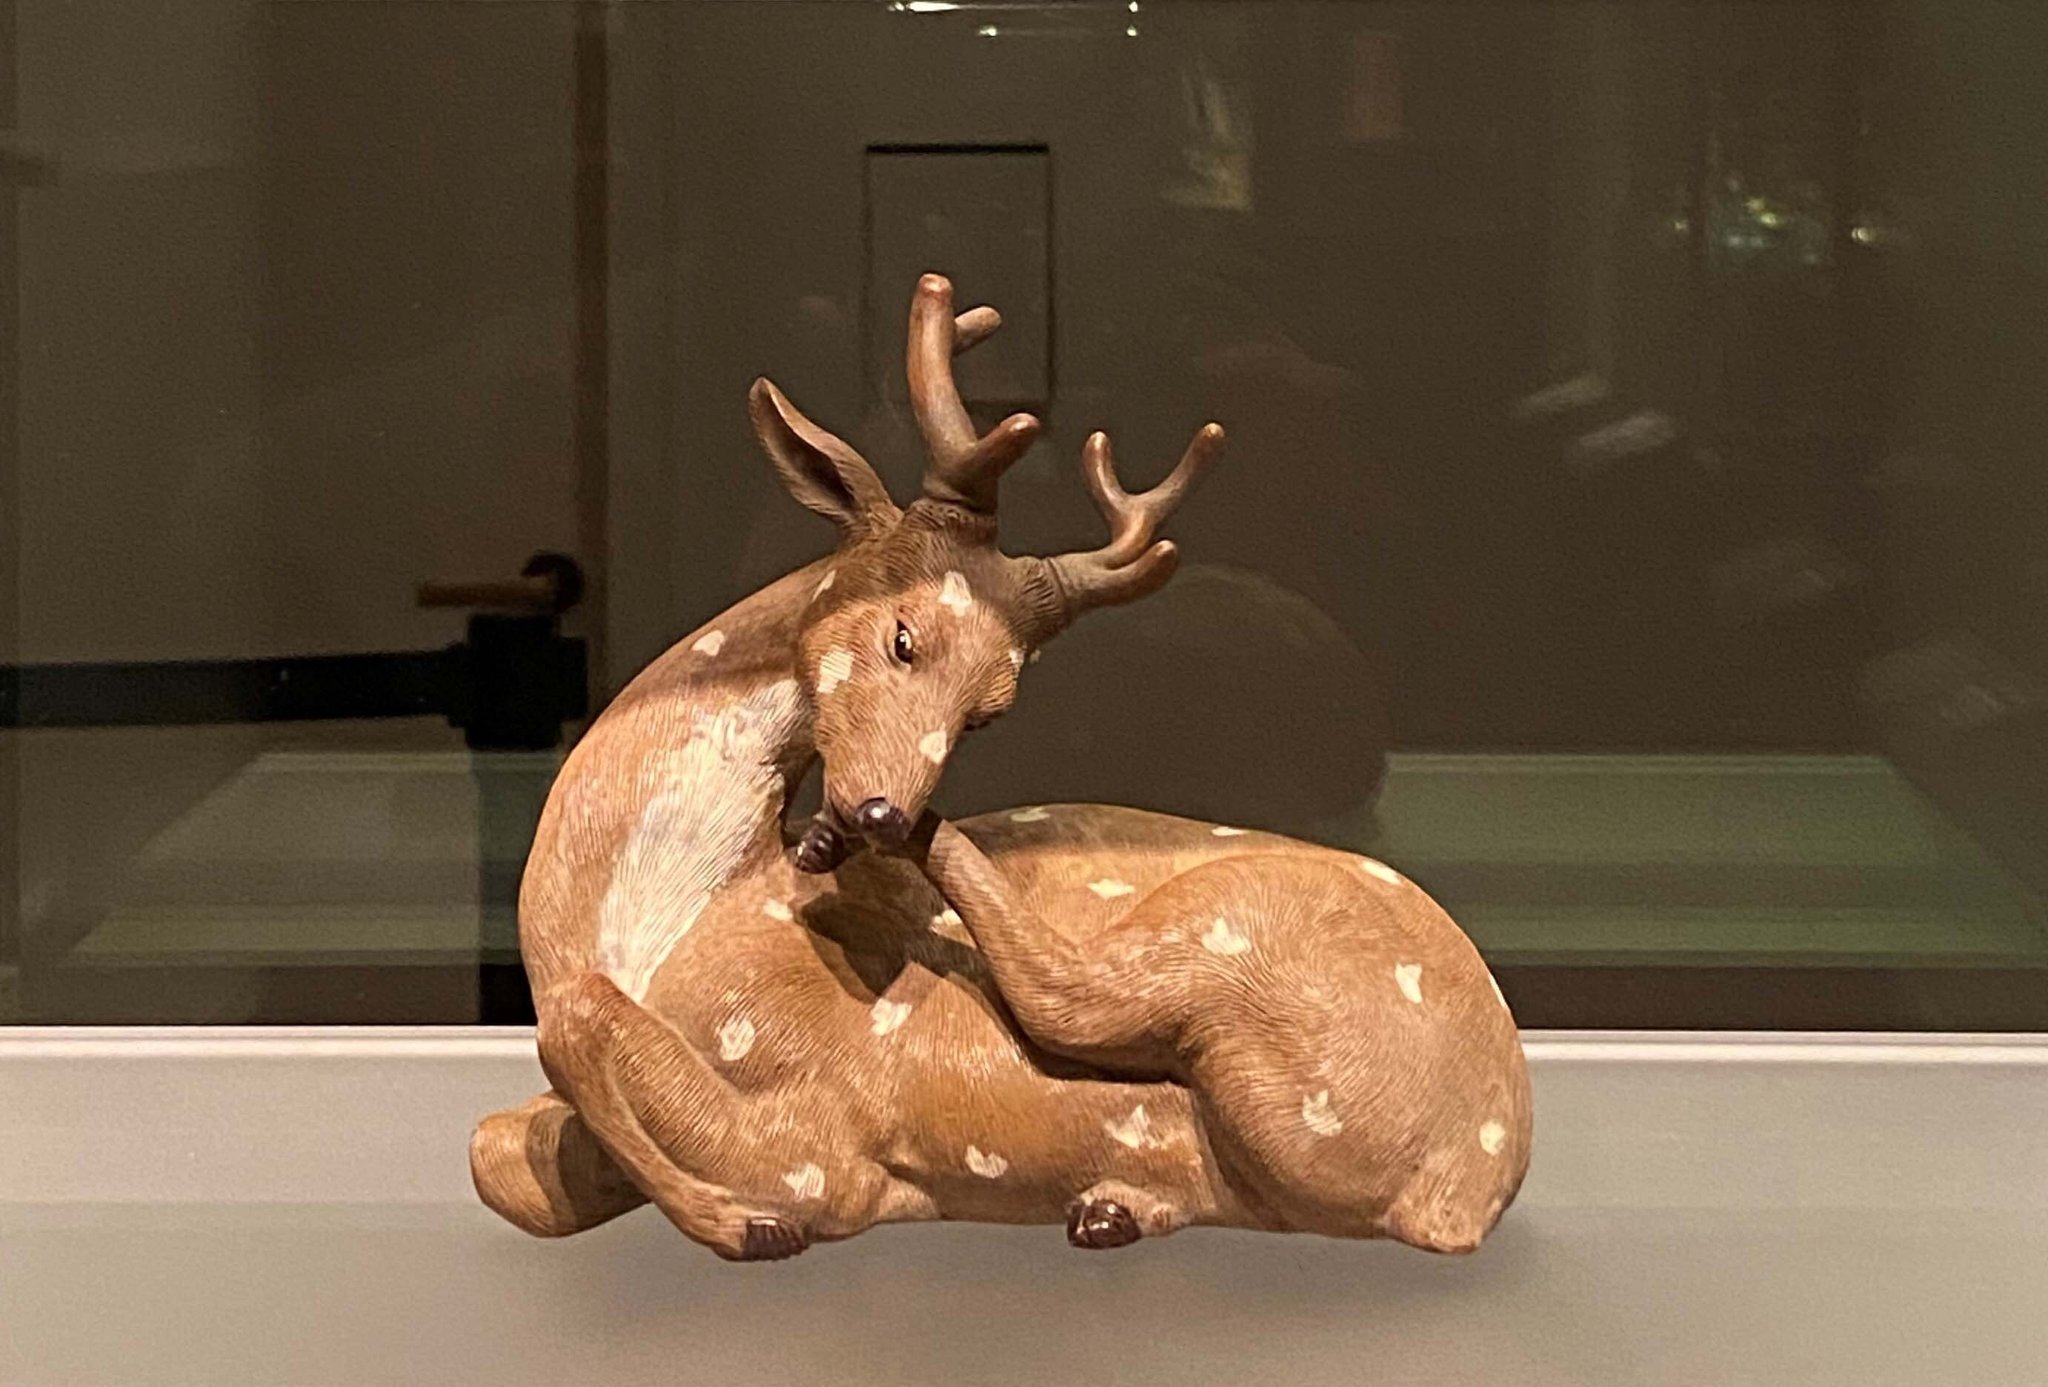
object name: statuette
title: Recumbent deer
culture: chinese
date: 1701-1800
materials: stoneware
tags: deer